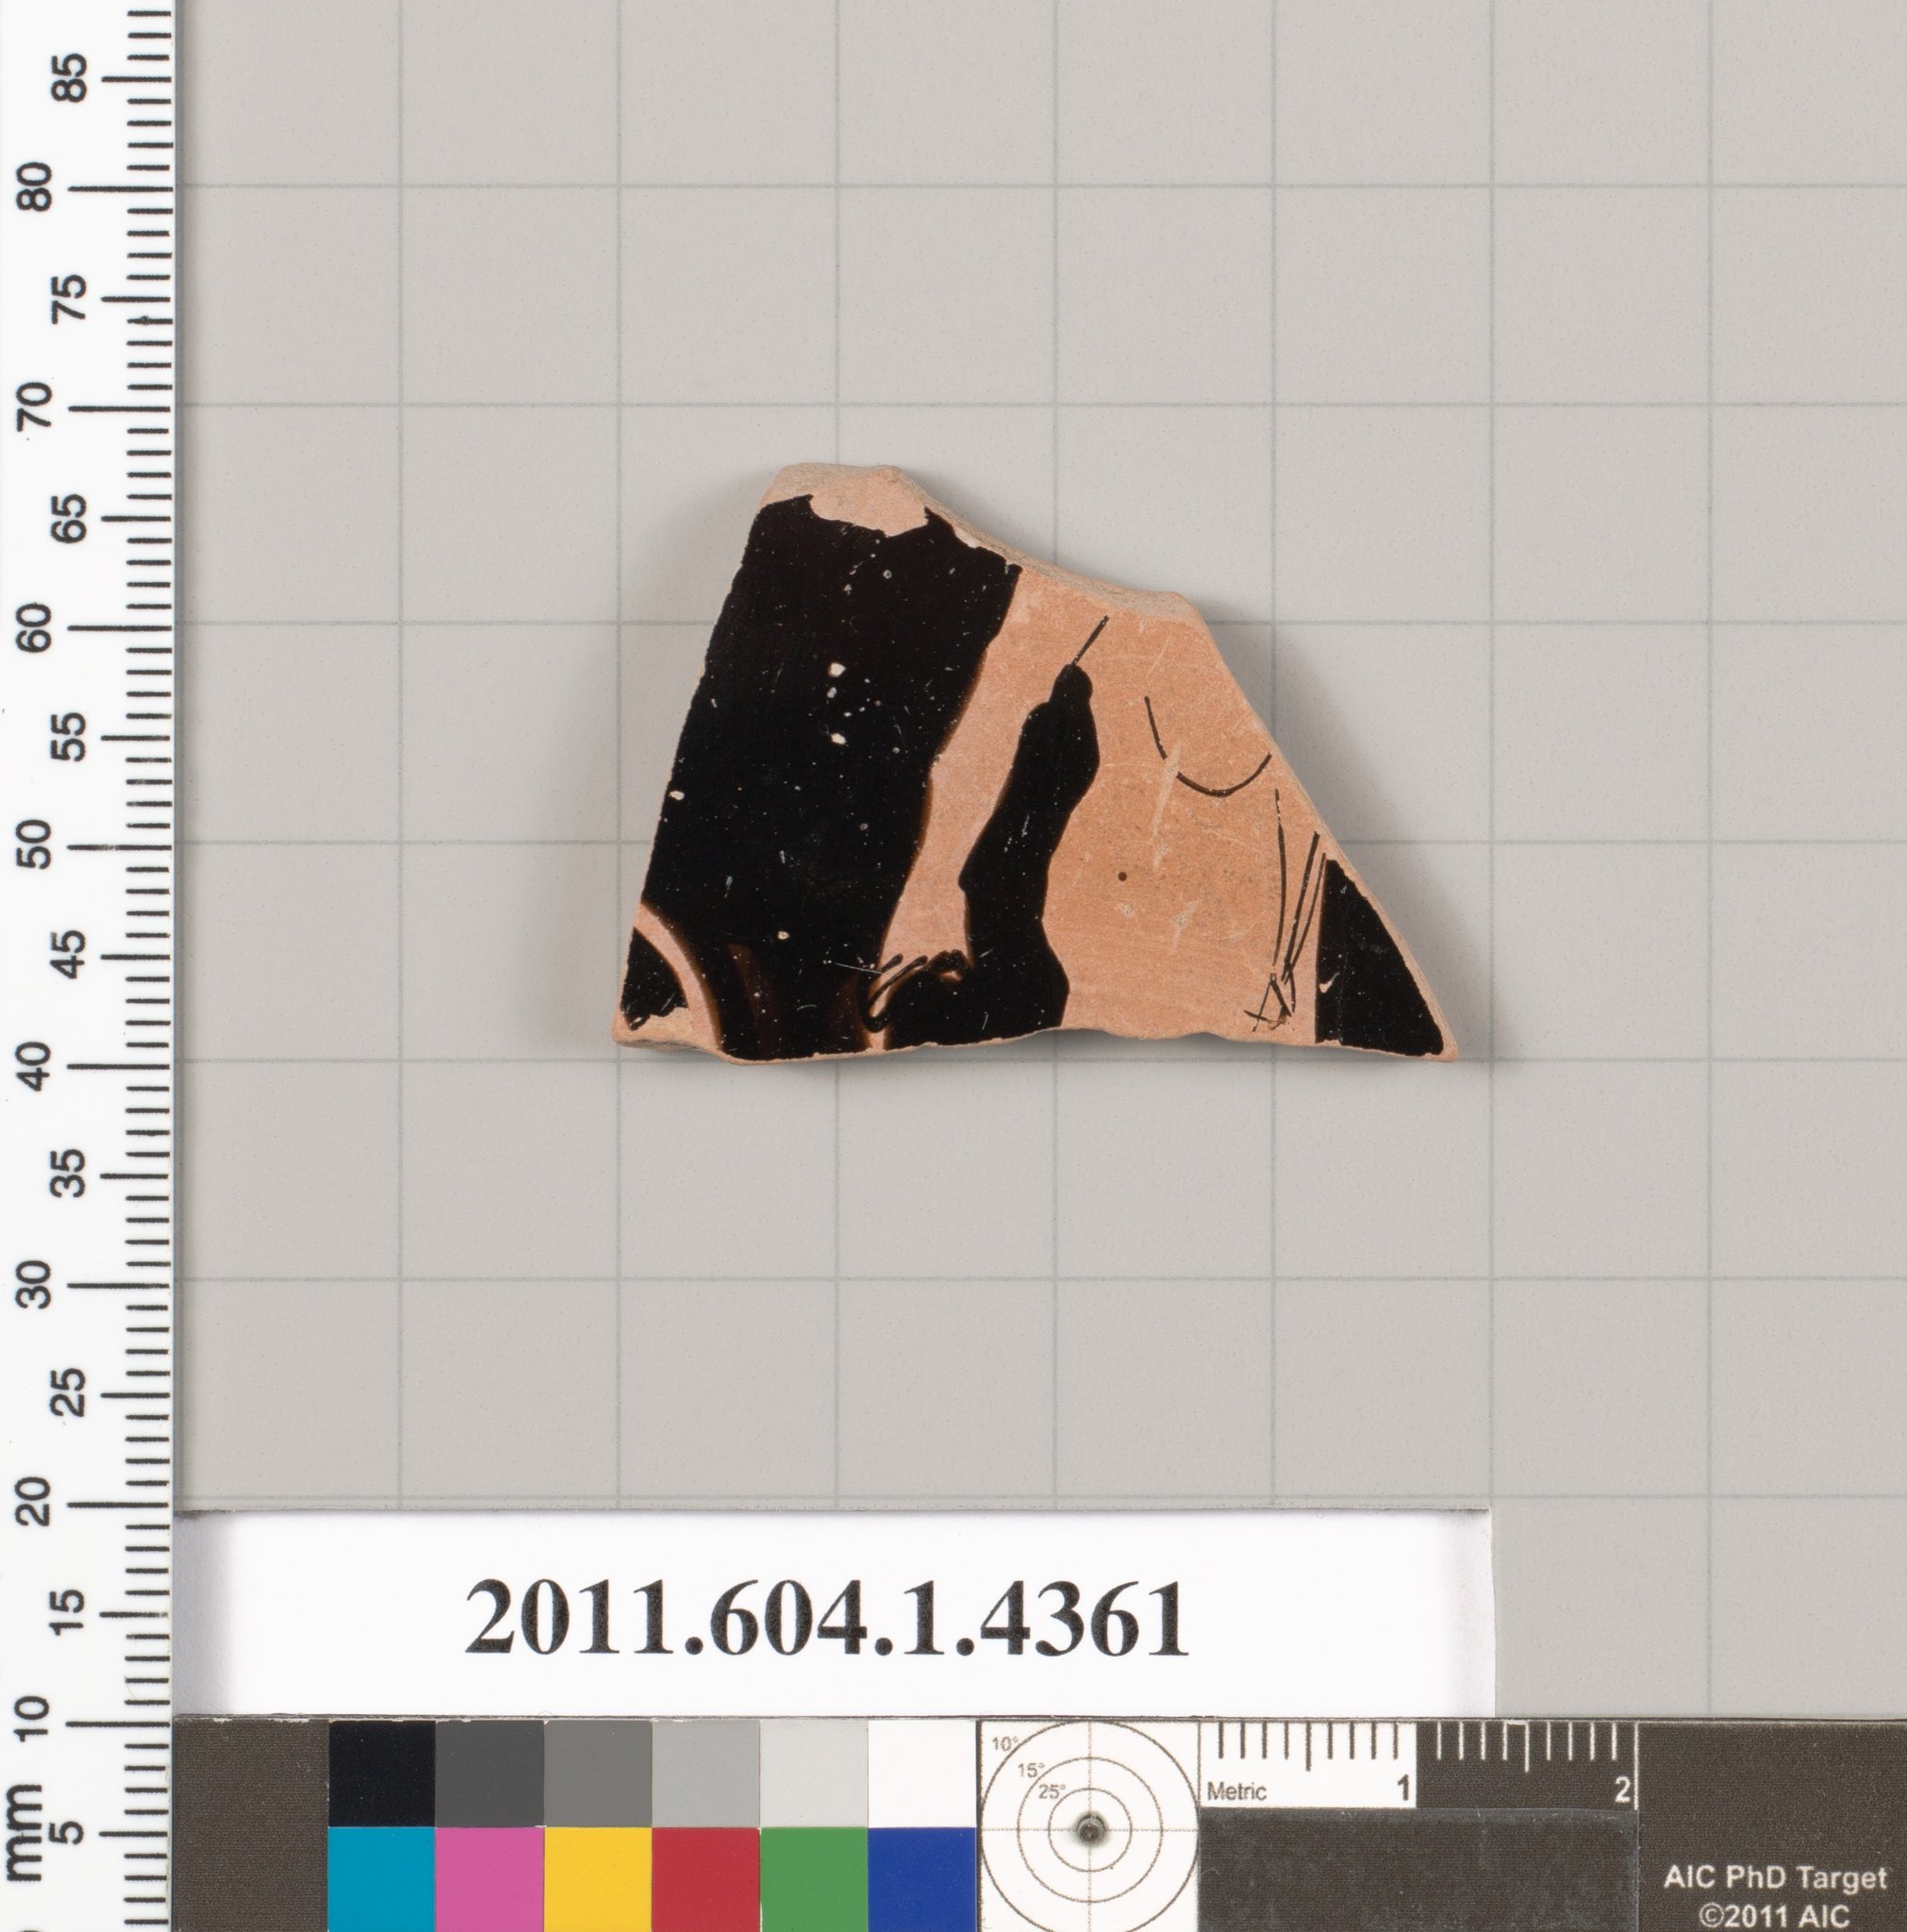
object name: kylix fragment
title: Terracotta fragment of a kylix (drinking cup)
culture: greek, attic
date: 467-435 BCE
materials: terracotta